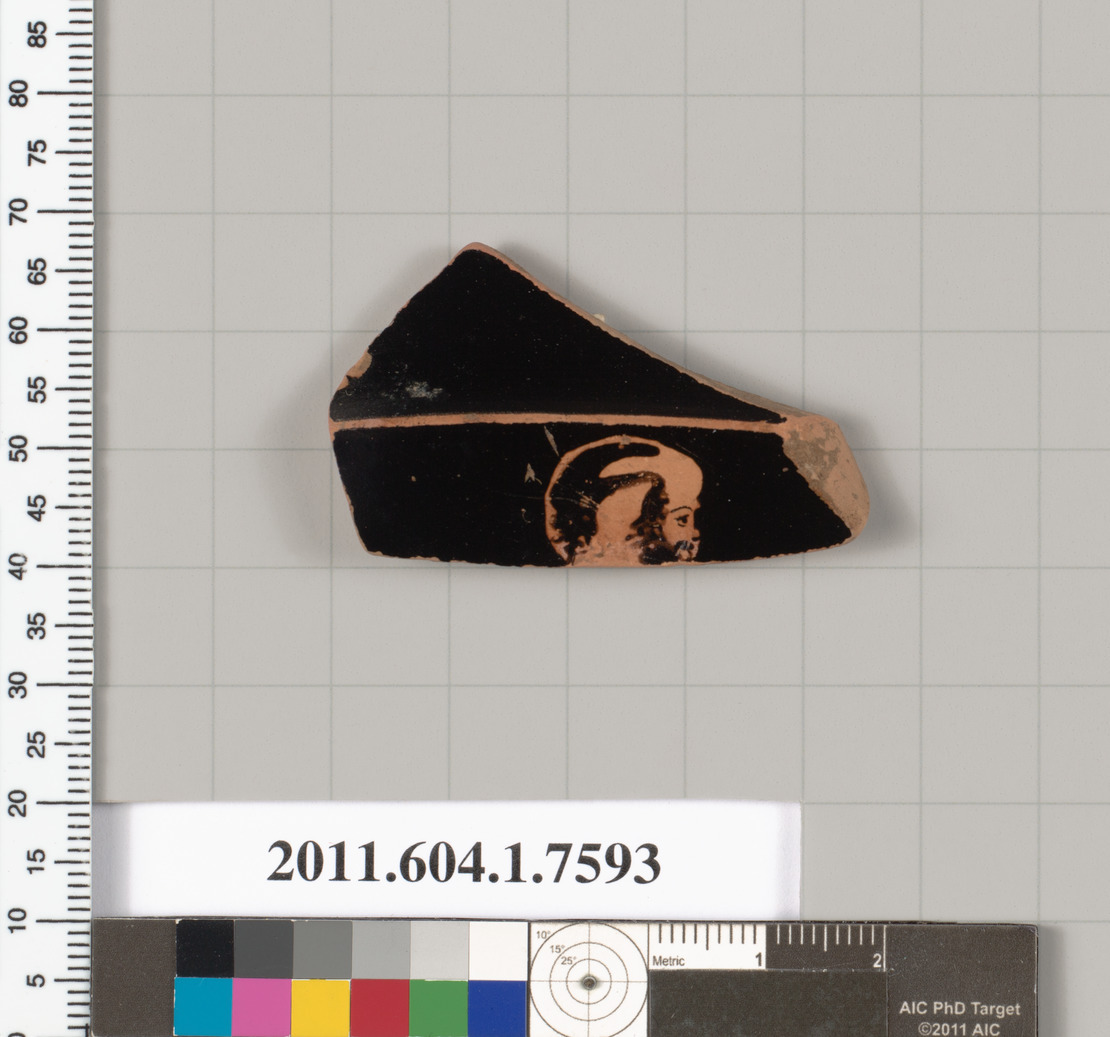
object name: kylix fragment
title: Terracotta fragment of a kylix (drinking cup)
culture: greek, attic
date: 460-450 BCE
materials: terracotta